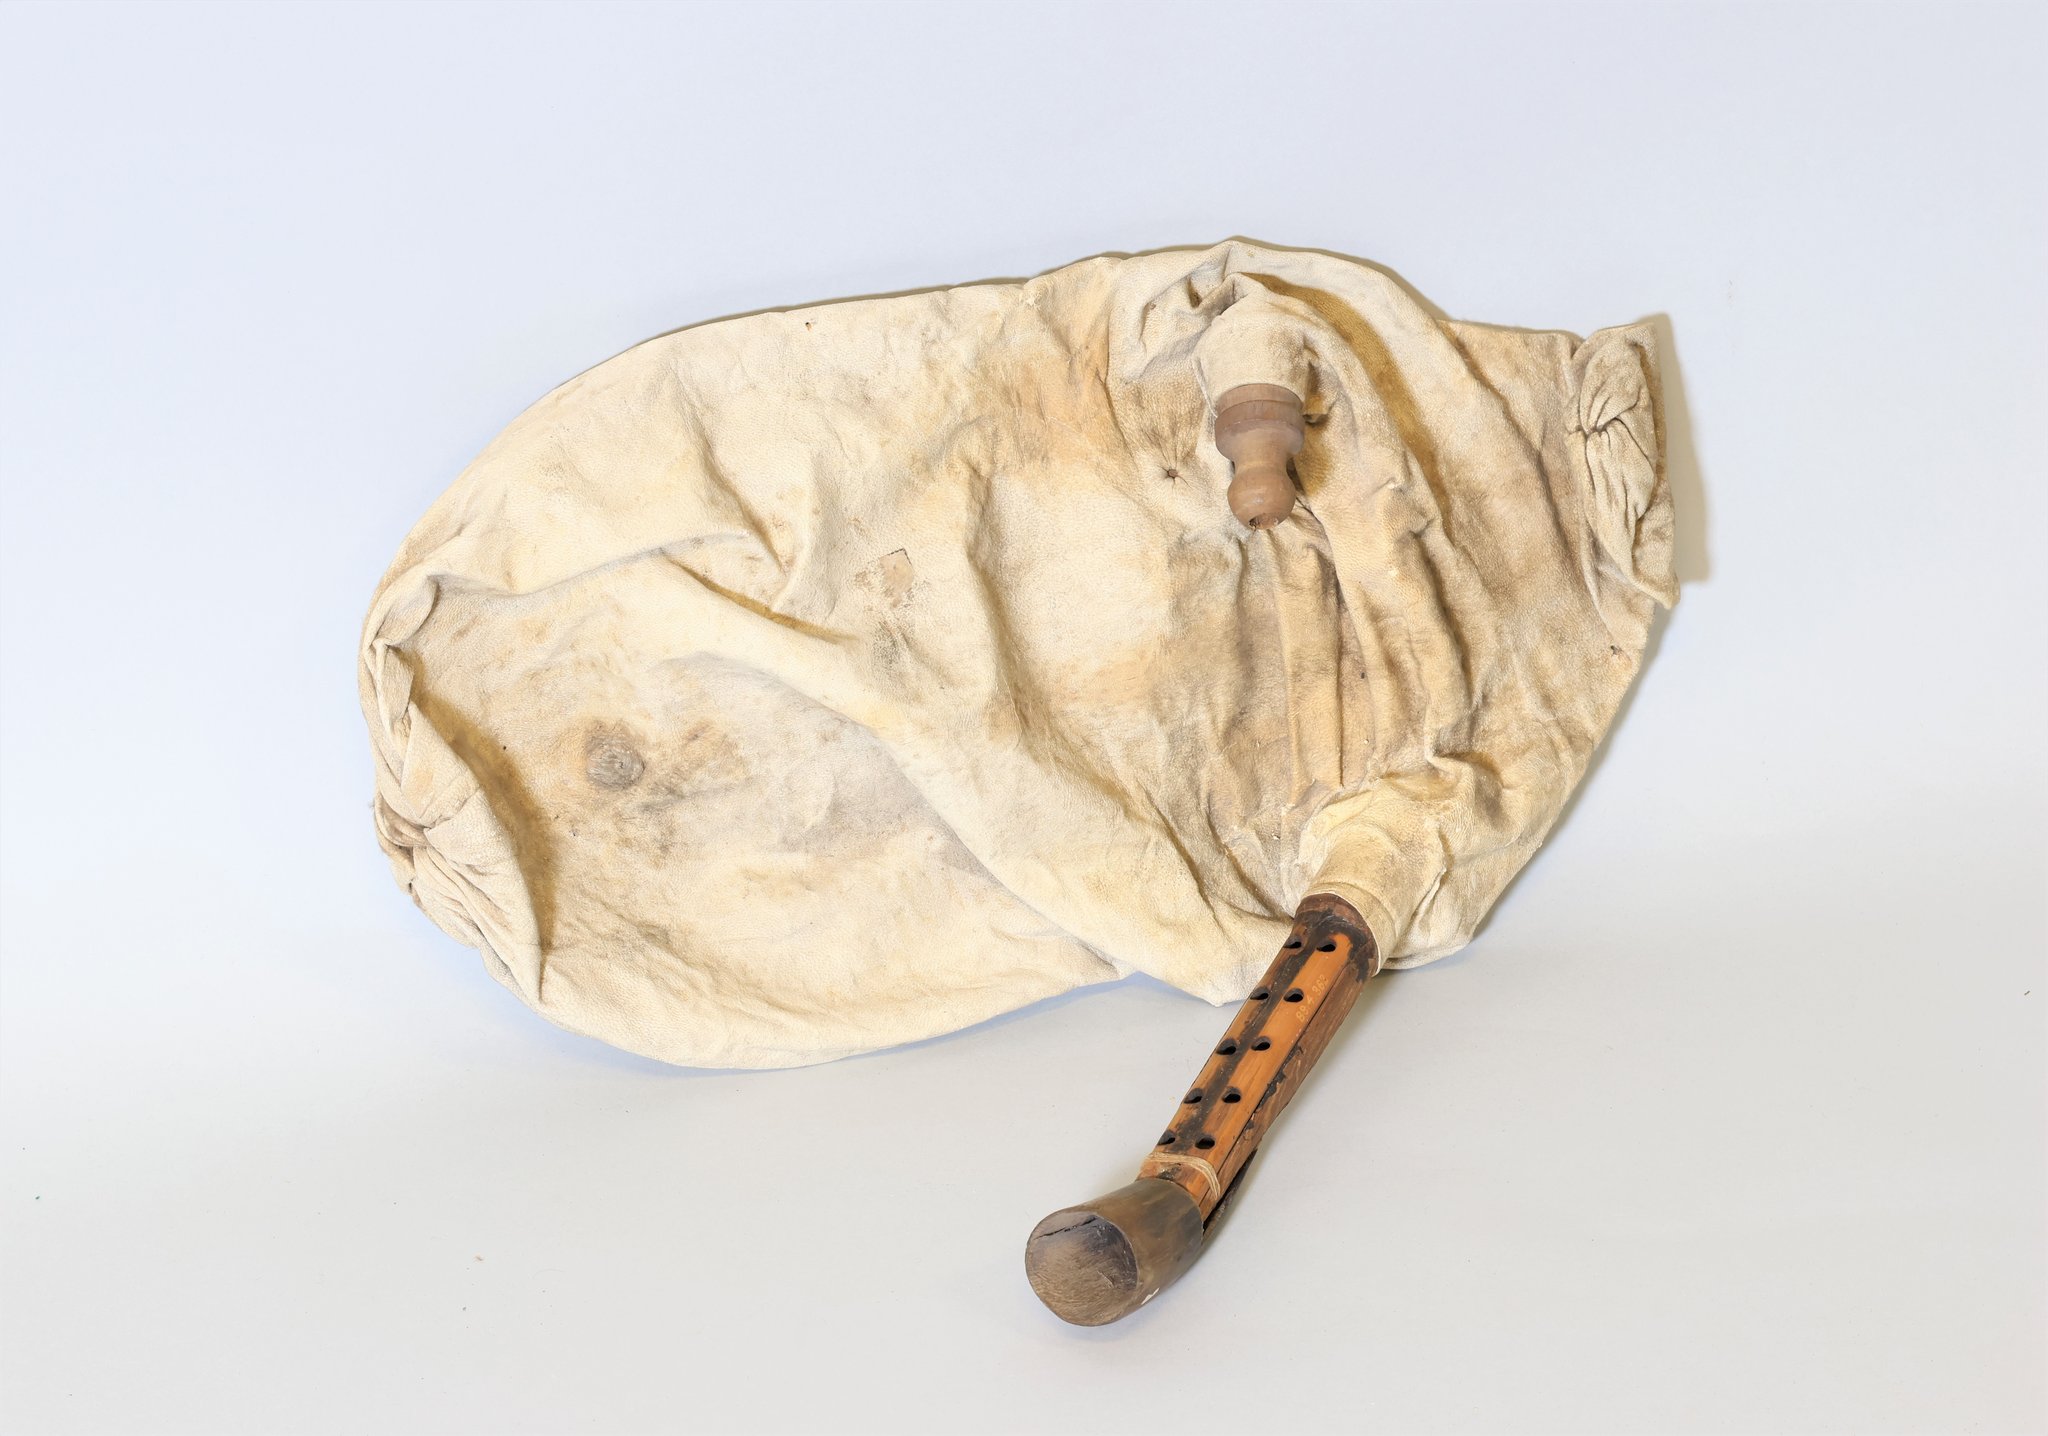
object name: tsambouna bagpipe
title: Tsambouna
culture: greek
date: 1867-1900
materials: leather, horn, wood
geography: greece